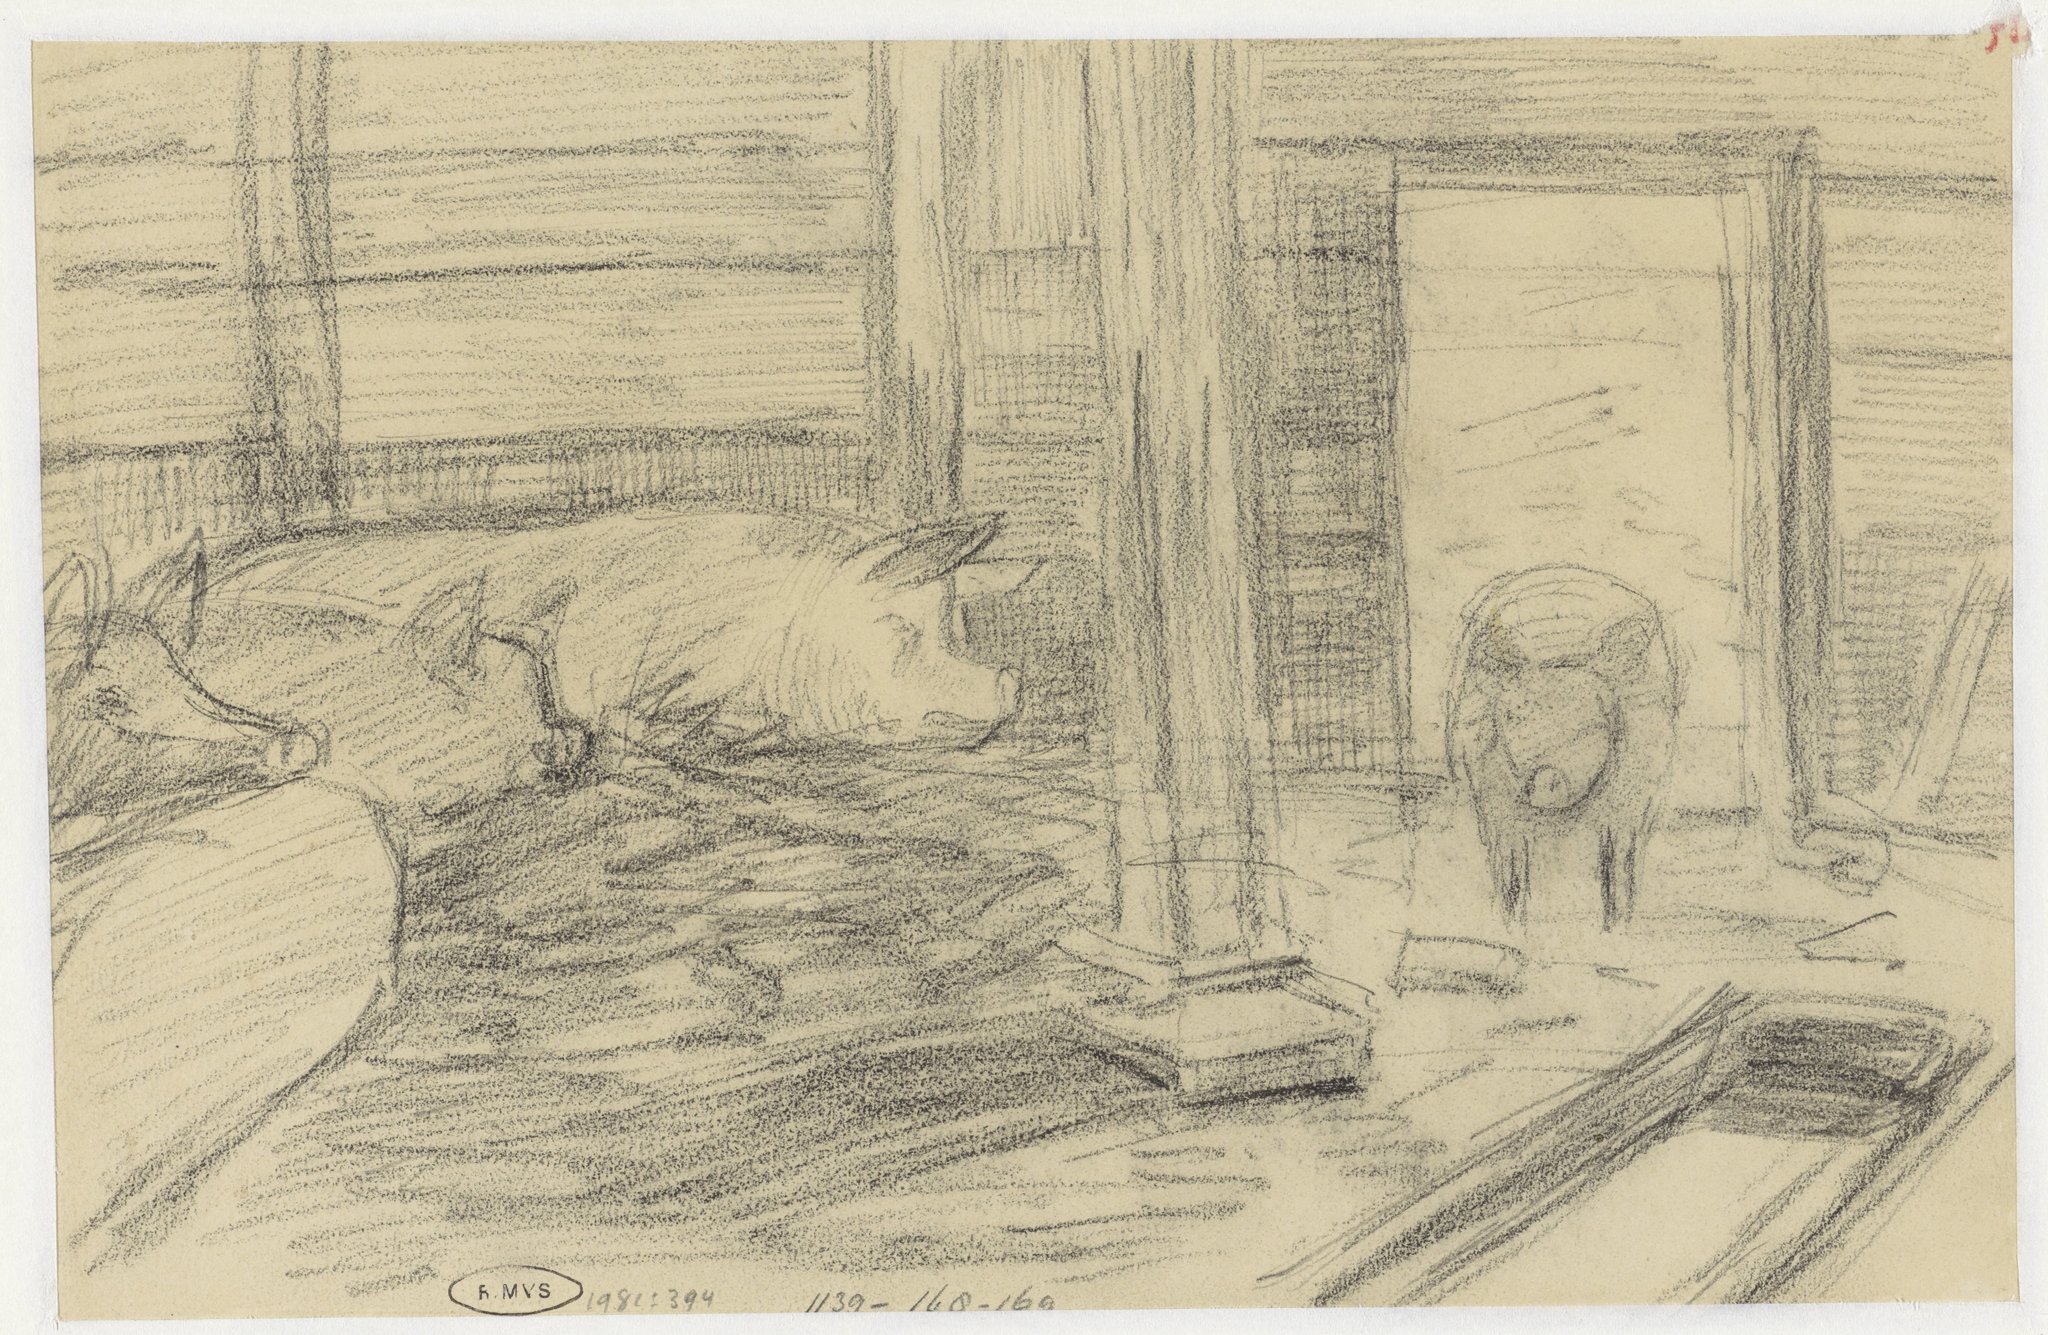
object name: drawing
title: Varkens in een stal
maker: jozef israëls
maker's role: draughtsman, painter, print maker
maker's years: 1824-1911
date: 1834-1911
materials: chalk, paper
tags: pig